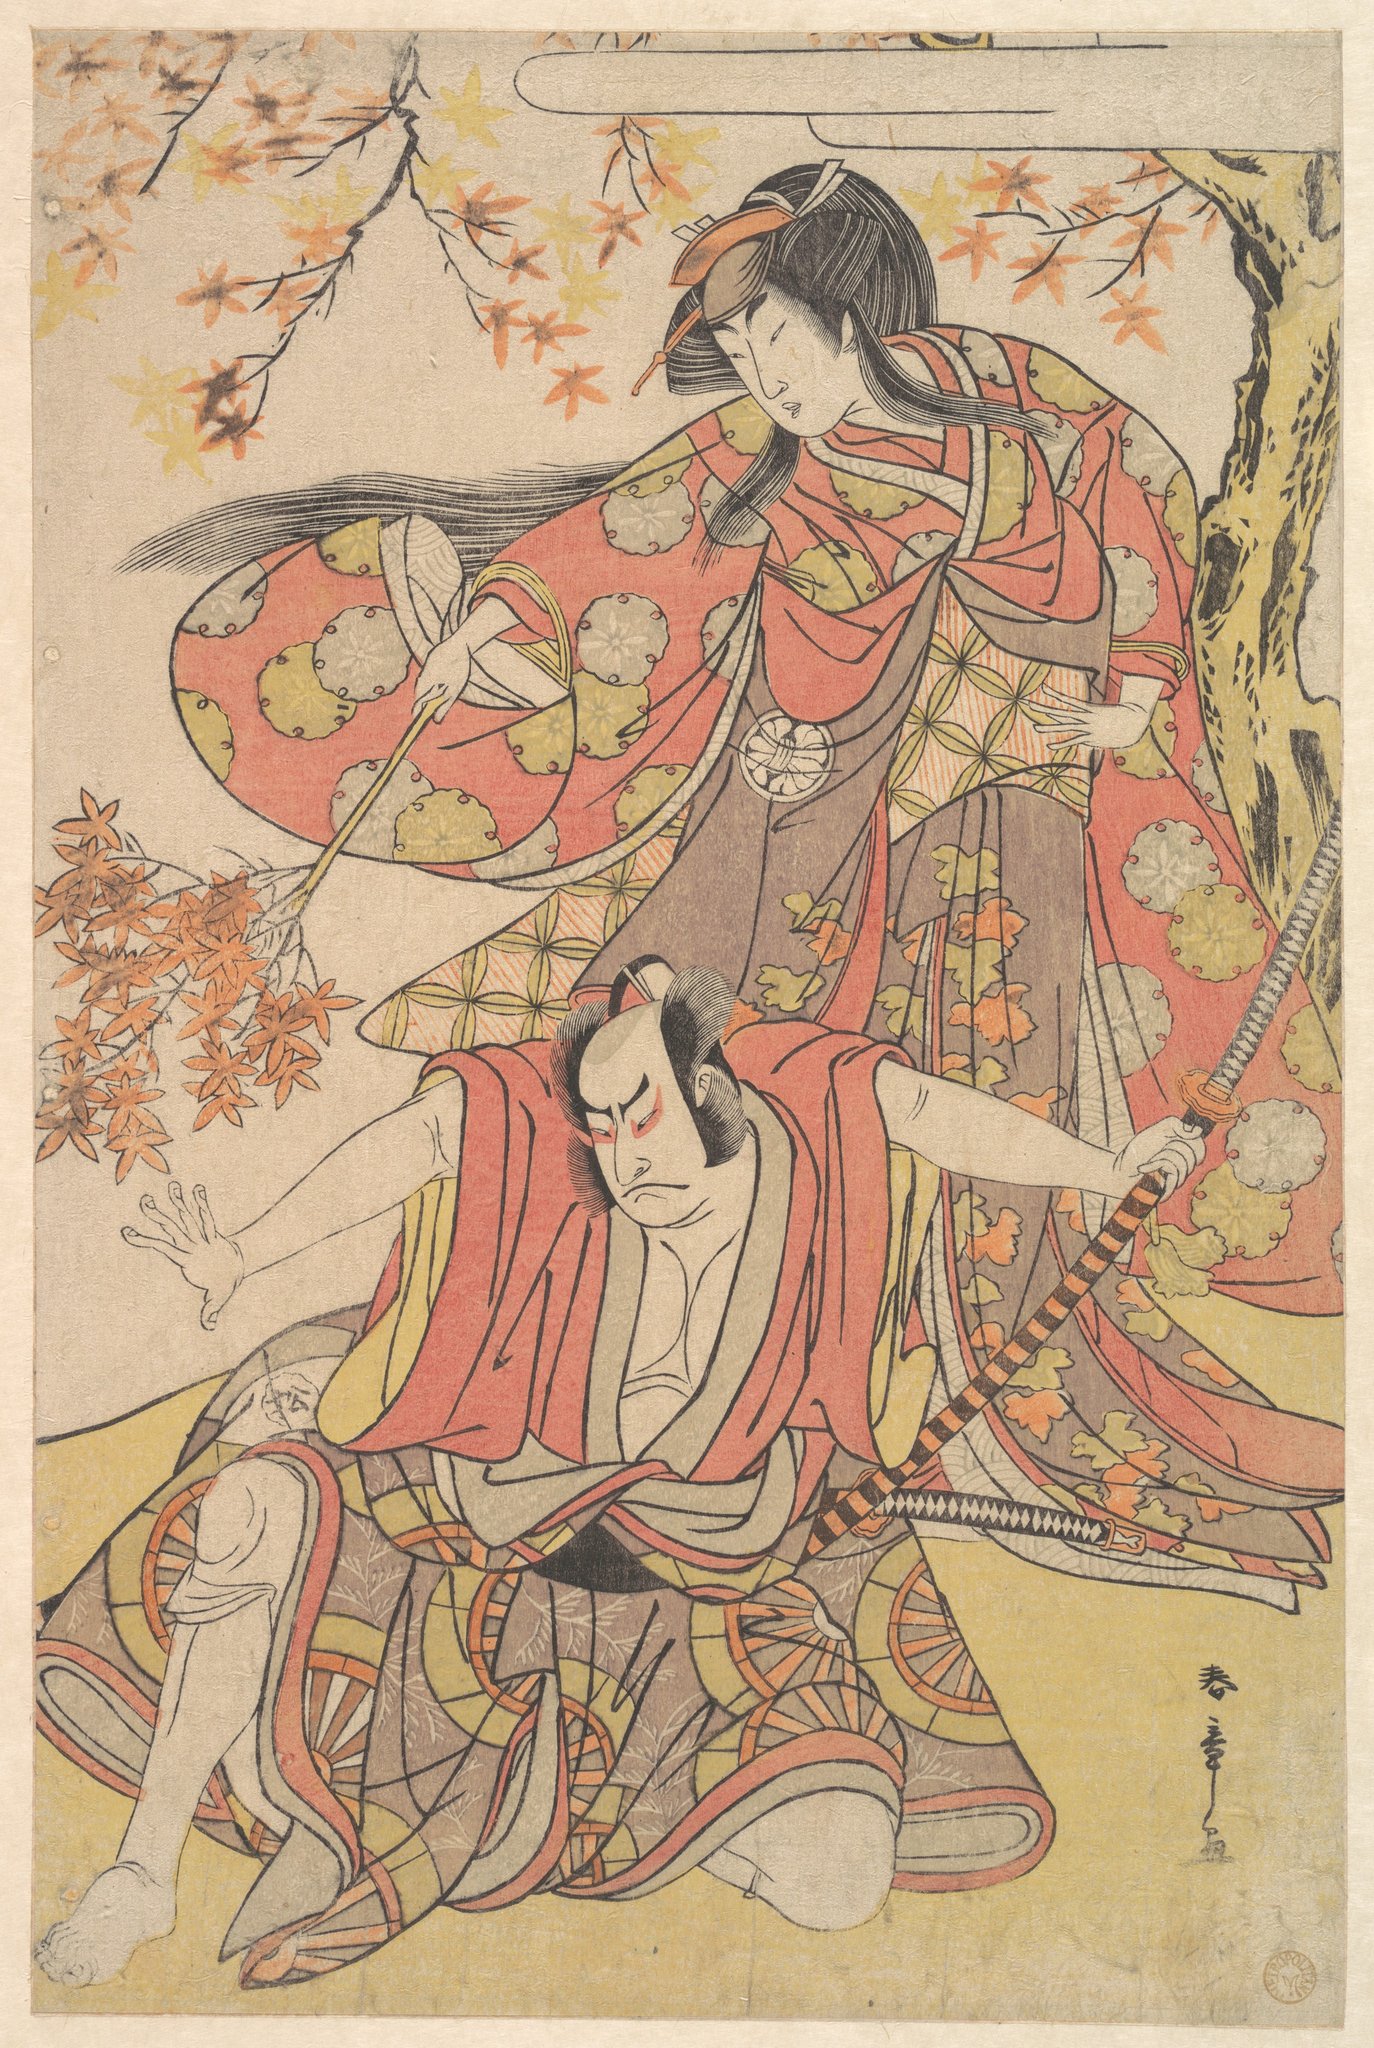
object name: woodblock print nishiki e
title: Segawa Kikunojo III as a Woman Standing under a Maple Tree in the Autumn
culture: japanese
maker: katsukawa shunshō 勝川春章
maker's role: artist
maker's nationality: japanese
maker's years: 1726-1792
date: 1778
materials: ink, paper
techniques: nishiki e, woodblock print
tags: swords,men,trees,autumn,actors